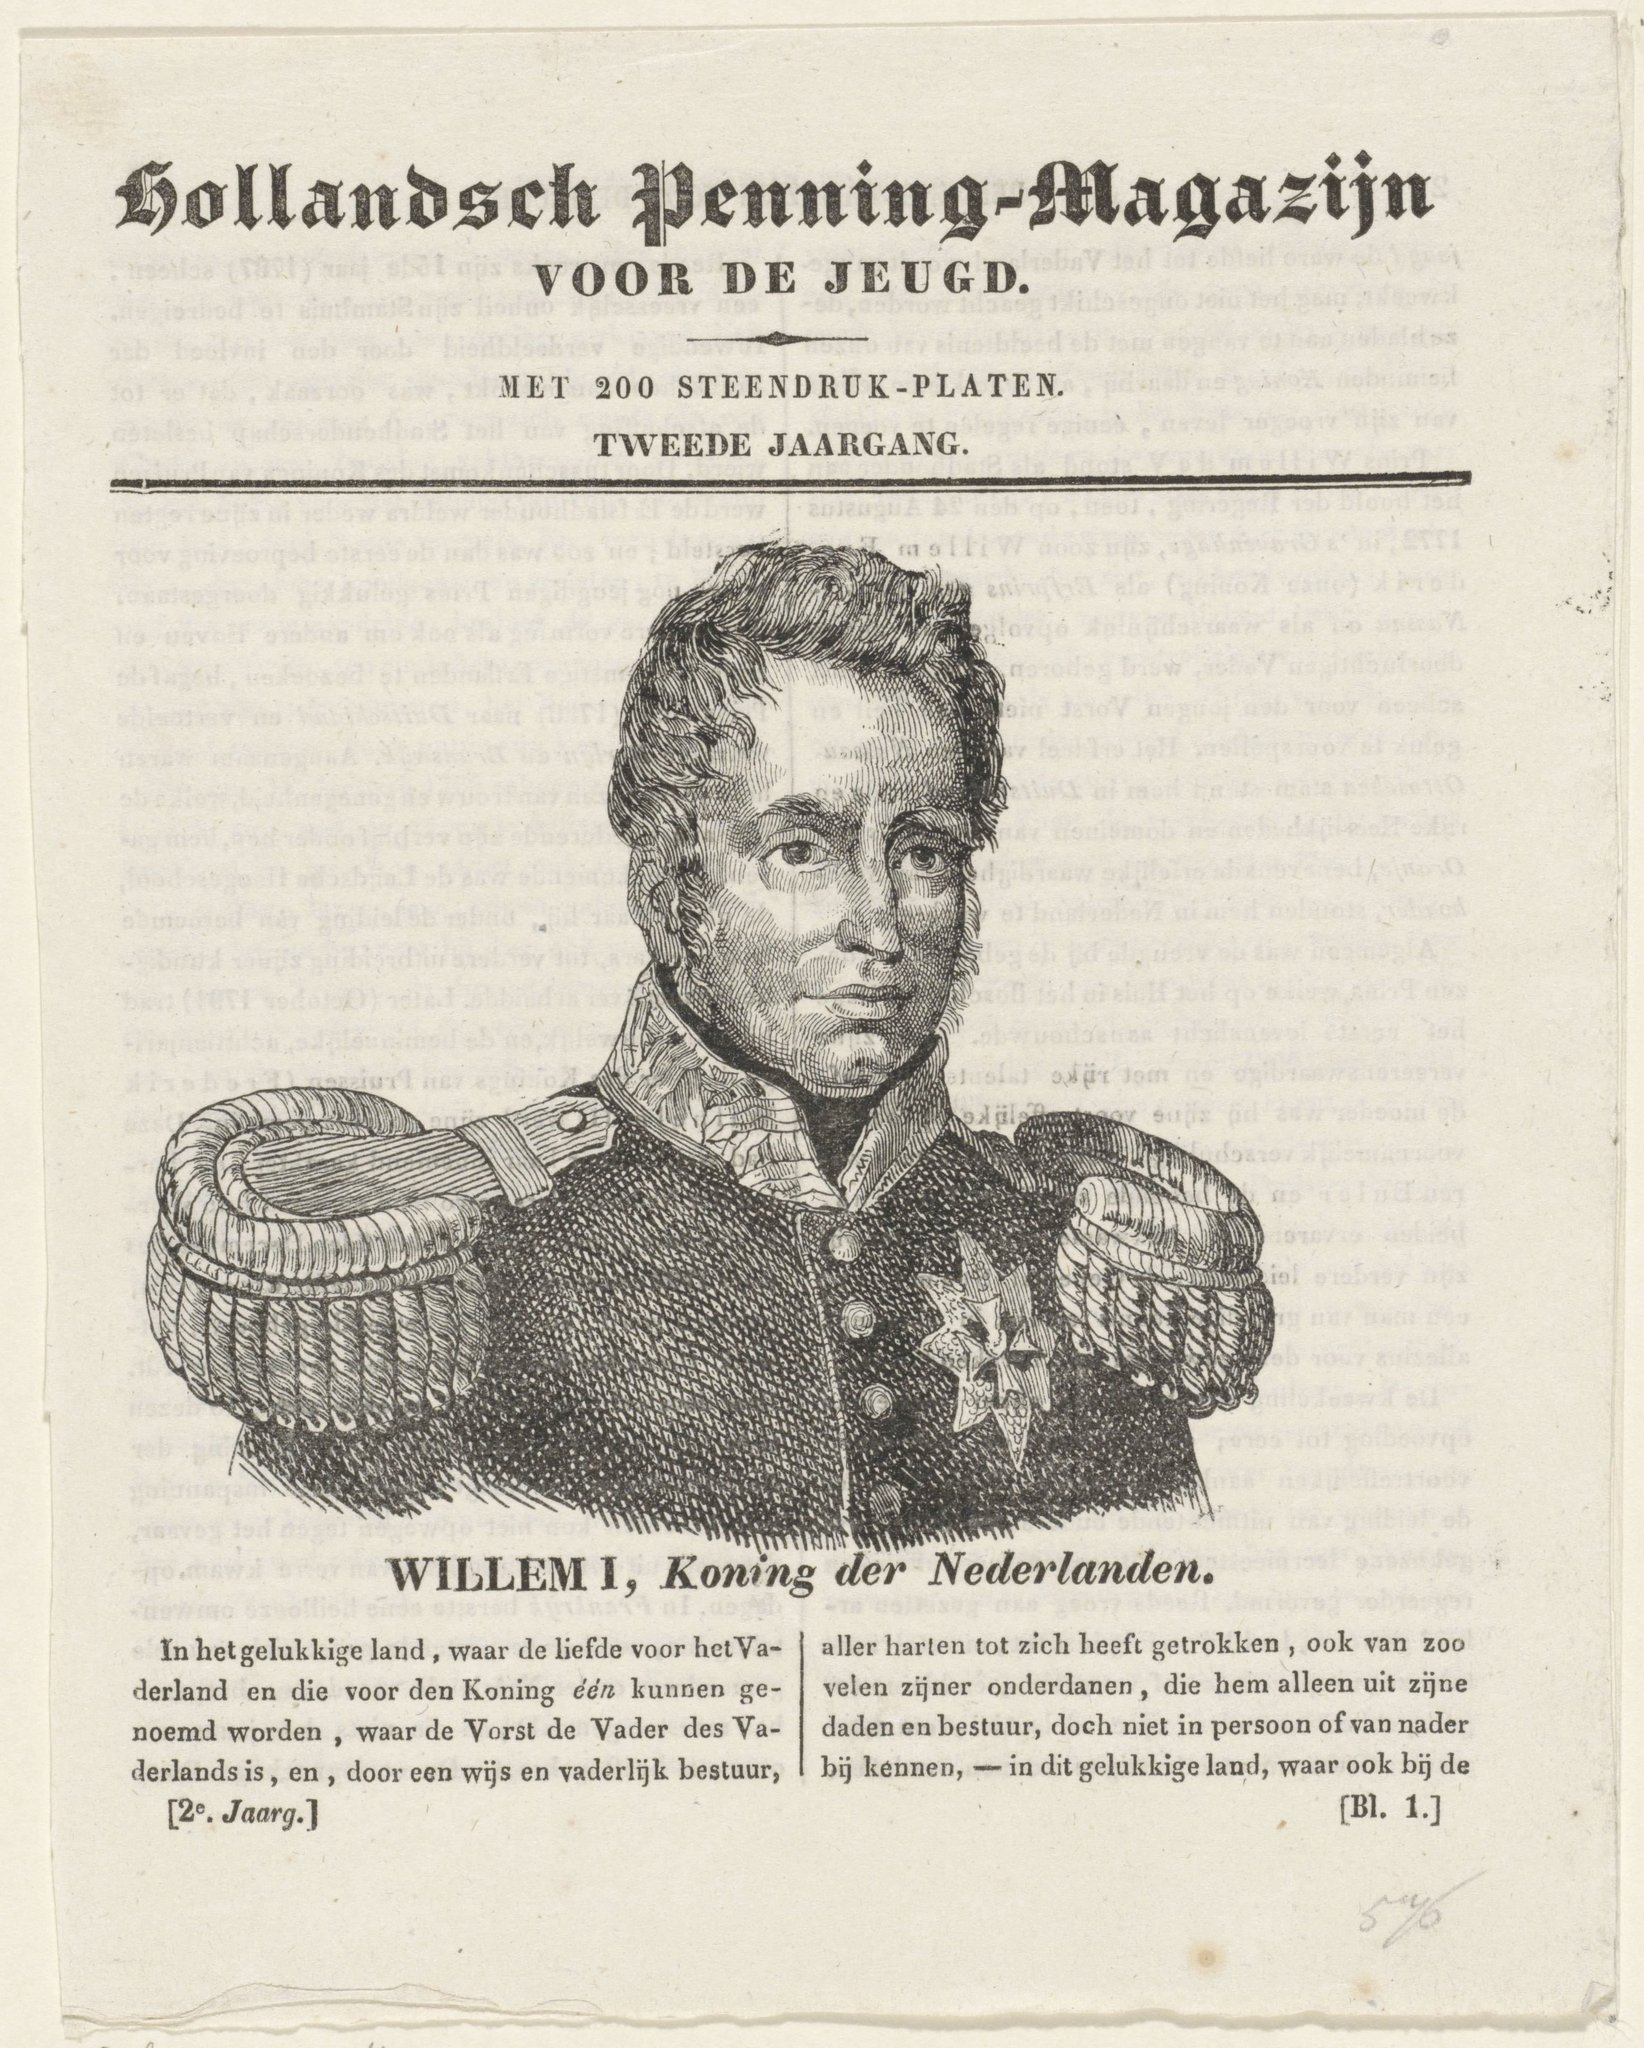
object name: book illustration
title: Portret van Willem I Frederik, koning der Nederlanden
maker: Anonymous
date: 1815-1899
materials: paper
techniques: etching, letterpress printing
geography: netherlands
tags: berlin, william i of the netherlands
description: De hier vermelde titel verwijst naar de hoogst verkregen titel van de geportretteerde, niet per se naar de titel die de geportretteerde op deze voorstelling draagt.